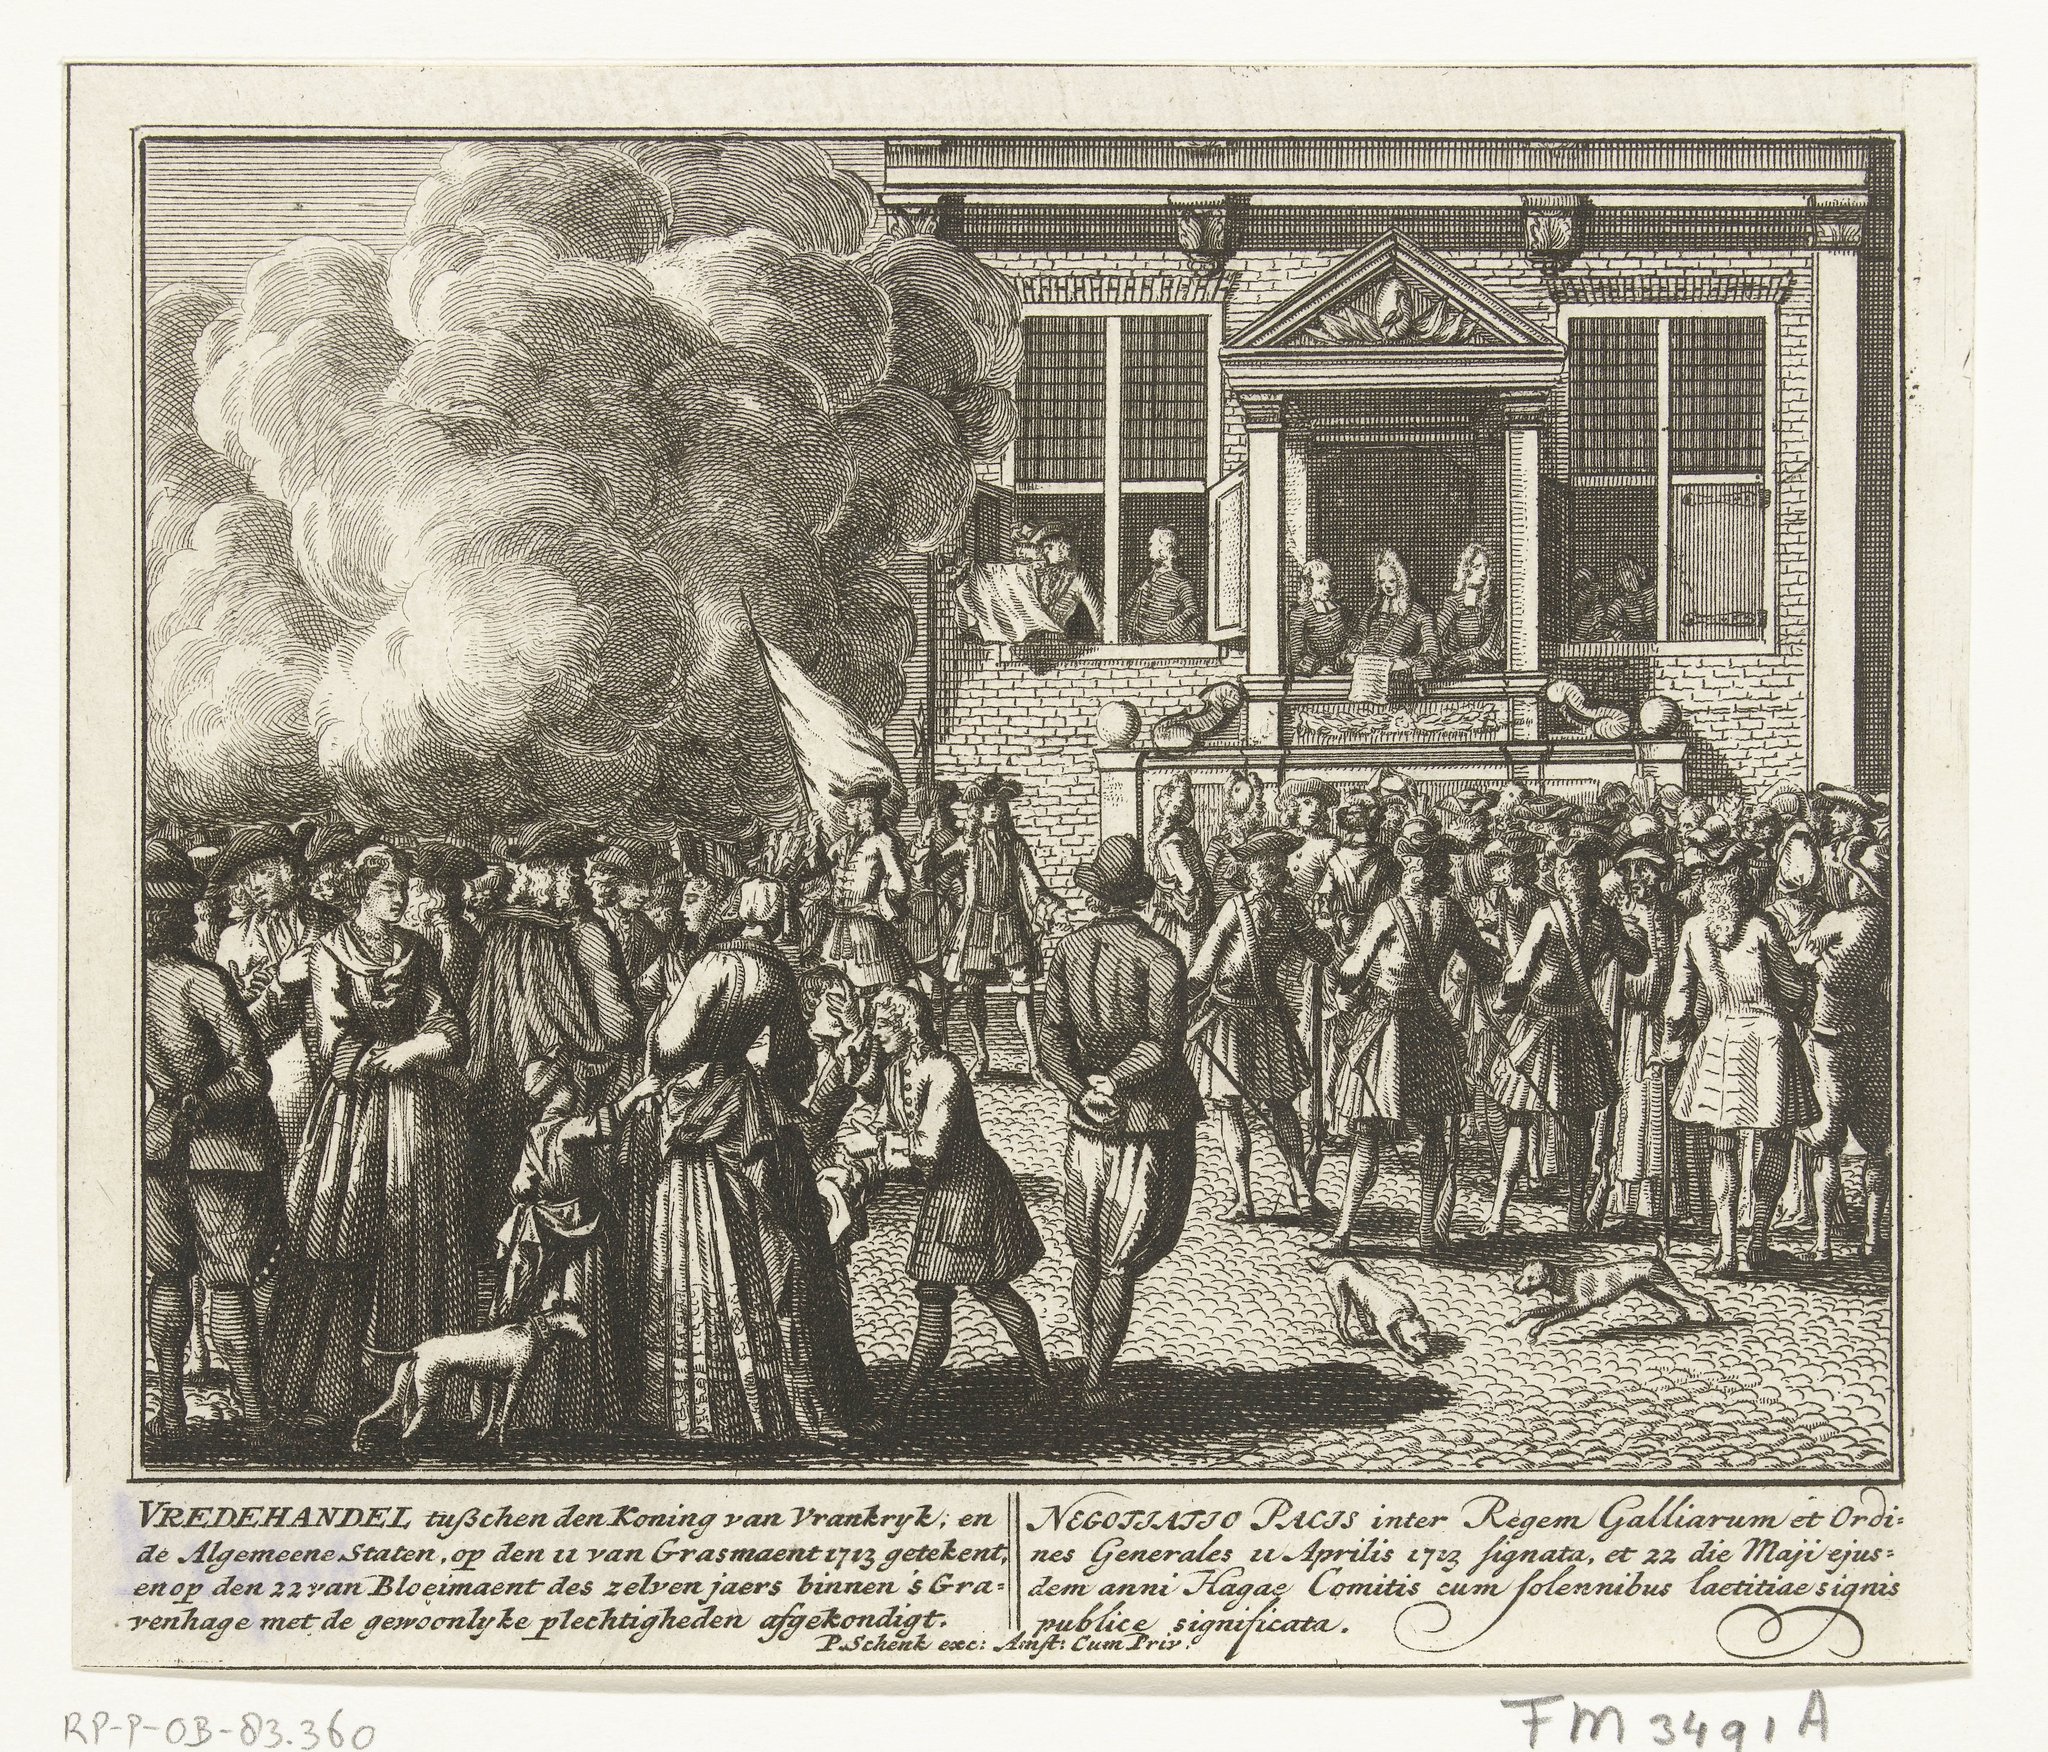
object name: print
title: Vredehandel tusschen den Koning van Vrankryk, en de Algemeene Staten, op den 11 van Grasmaent 1713 getekent (...)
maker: pieter schenk (i)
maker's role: print maker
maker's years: 1660-1711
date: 1713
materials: paper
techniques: etching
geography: northern netherlands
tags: proclamation of peace, the hague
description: Afkondiging van de Vrede van Utrecht te Den Haag op 22 mei 1713. Met onderschriften in het Nederlands en Latijn. Fragment van een grote plaat met negen voorstellingen van gebeurtenissen uit het jaar 1712 van de Spaanse Successieoorlog.